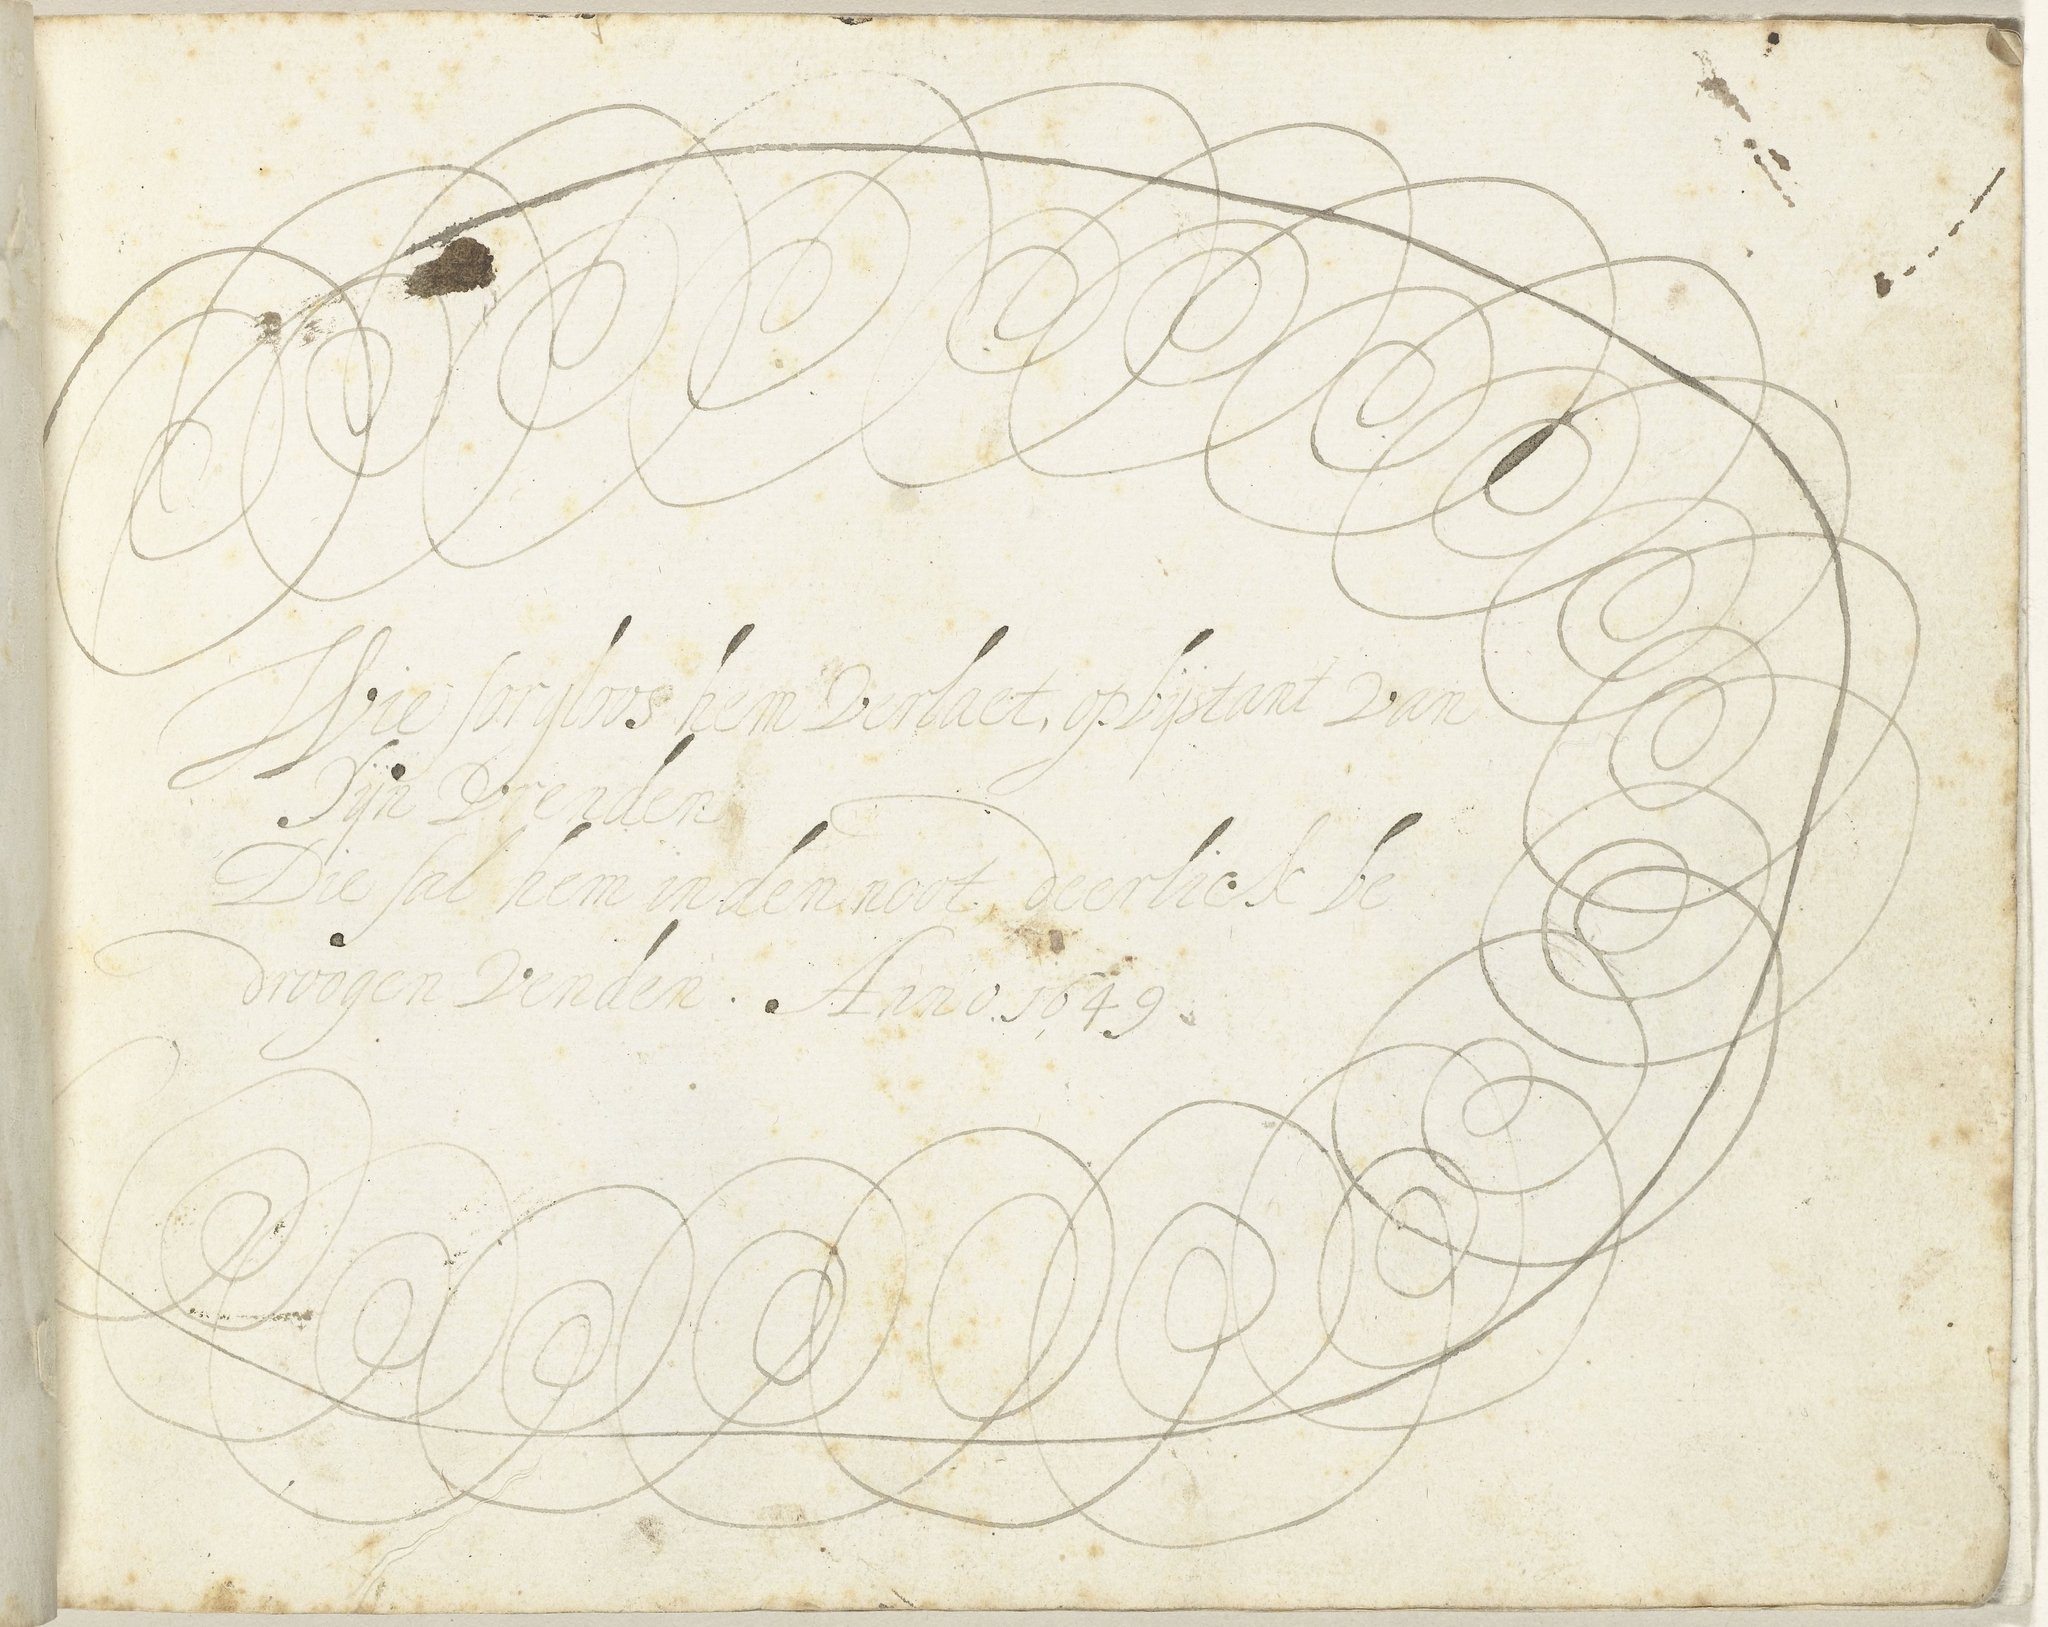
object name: calligraphy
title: Aforisme over vriendschap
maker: gesina ter borch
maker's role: draughtsman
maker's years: 1633-1690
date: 1649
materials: ink, paper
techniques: calligraphy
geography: zwolle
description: Hetzelfde aforisme staat ook op folio 73 van het Poëzie-album en GS 5.